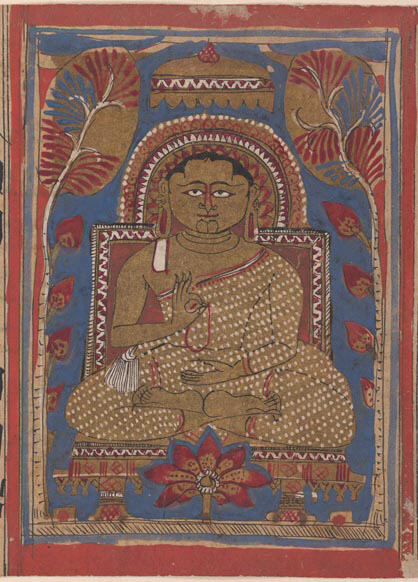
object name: folio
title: The Attainment of Perfect Knowledge (Siddha) by Mahavira's Disciple Indrabhuti Gautama: Folio from a Kalpasutra Manuscript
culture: indian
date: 1401-1500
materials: gold, ink, paper, watercolor